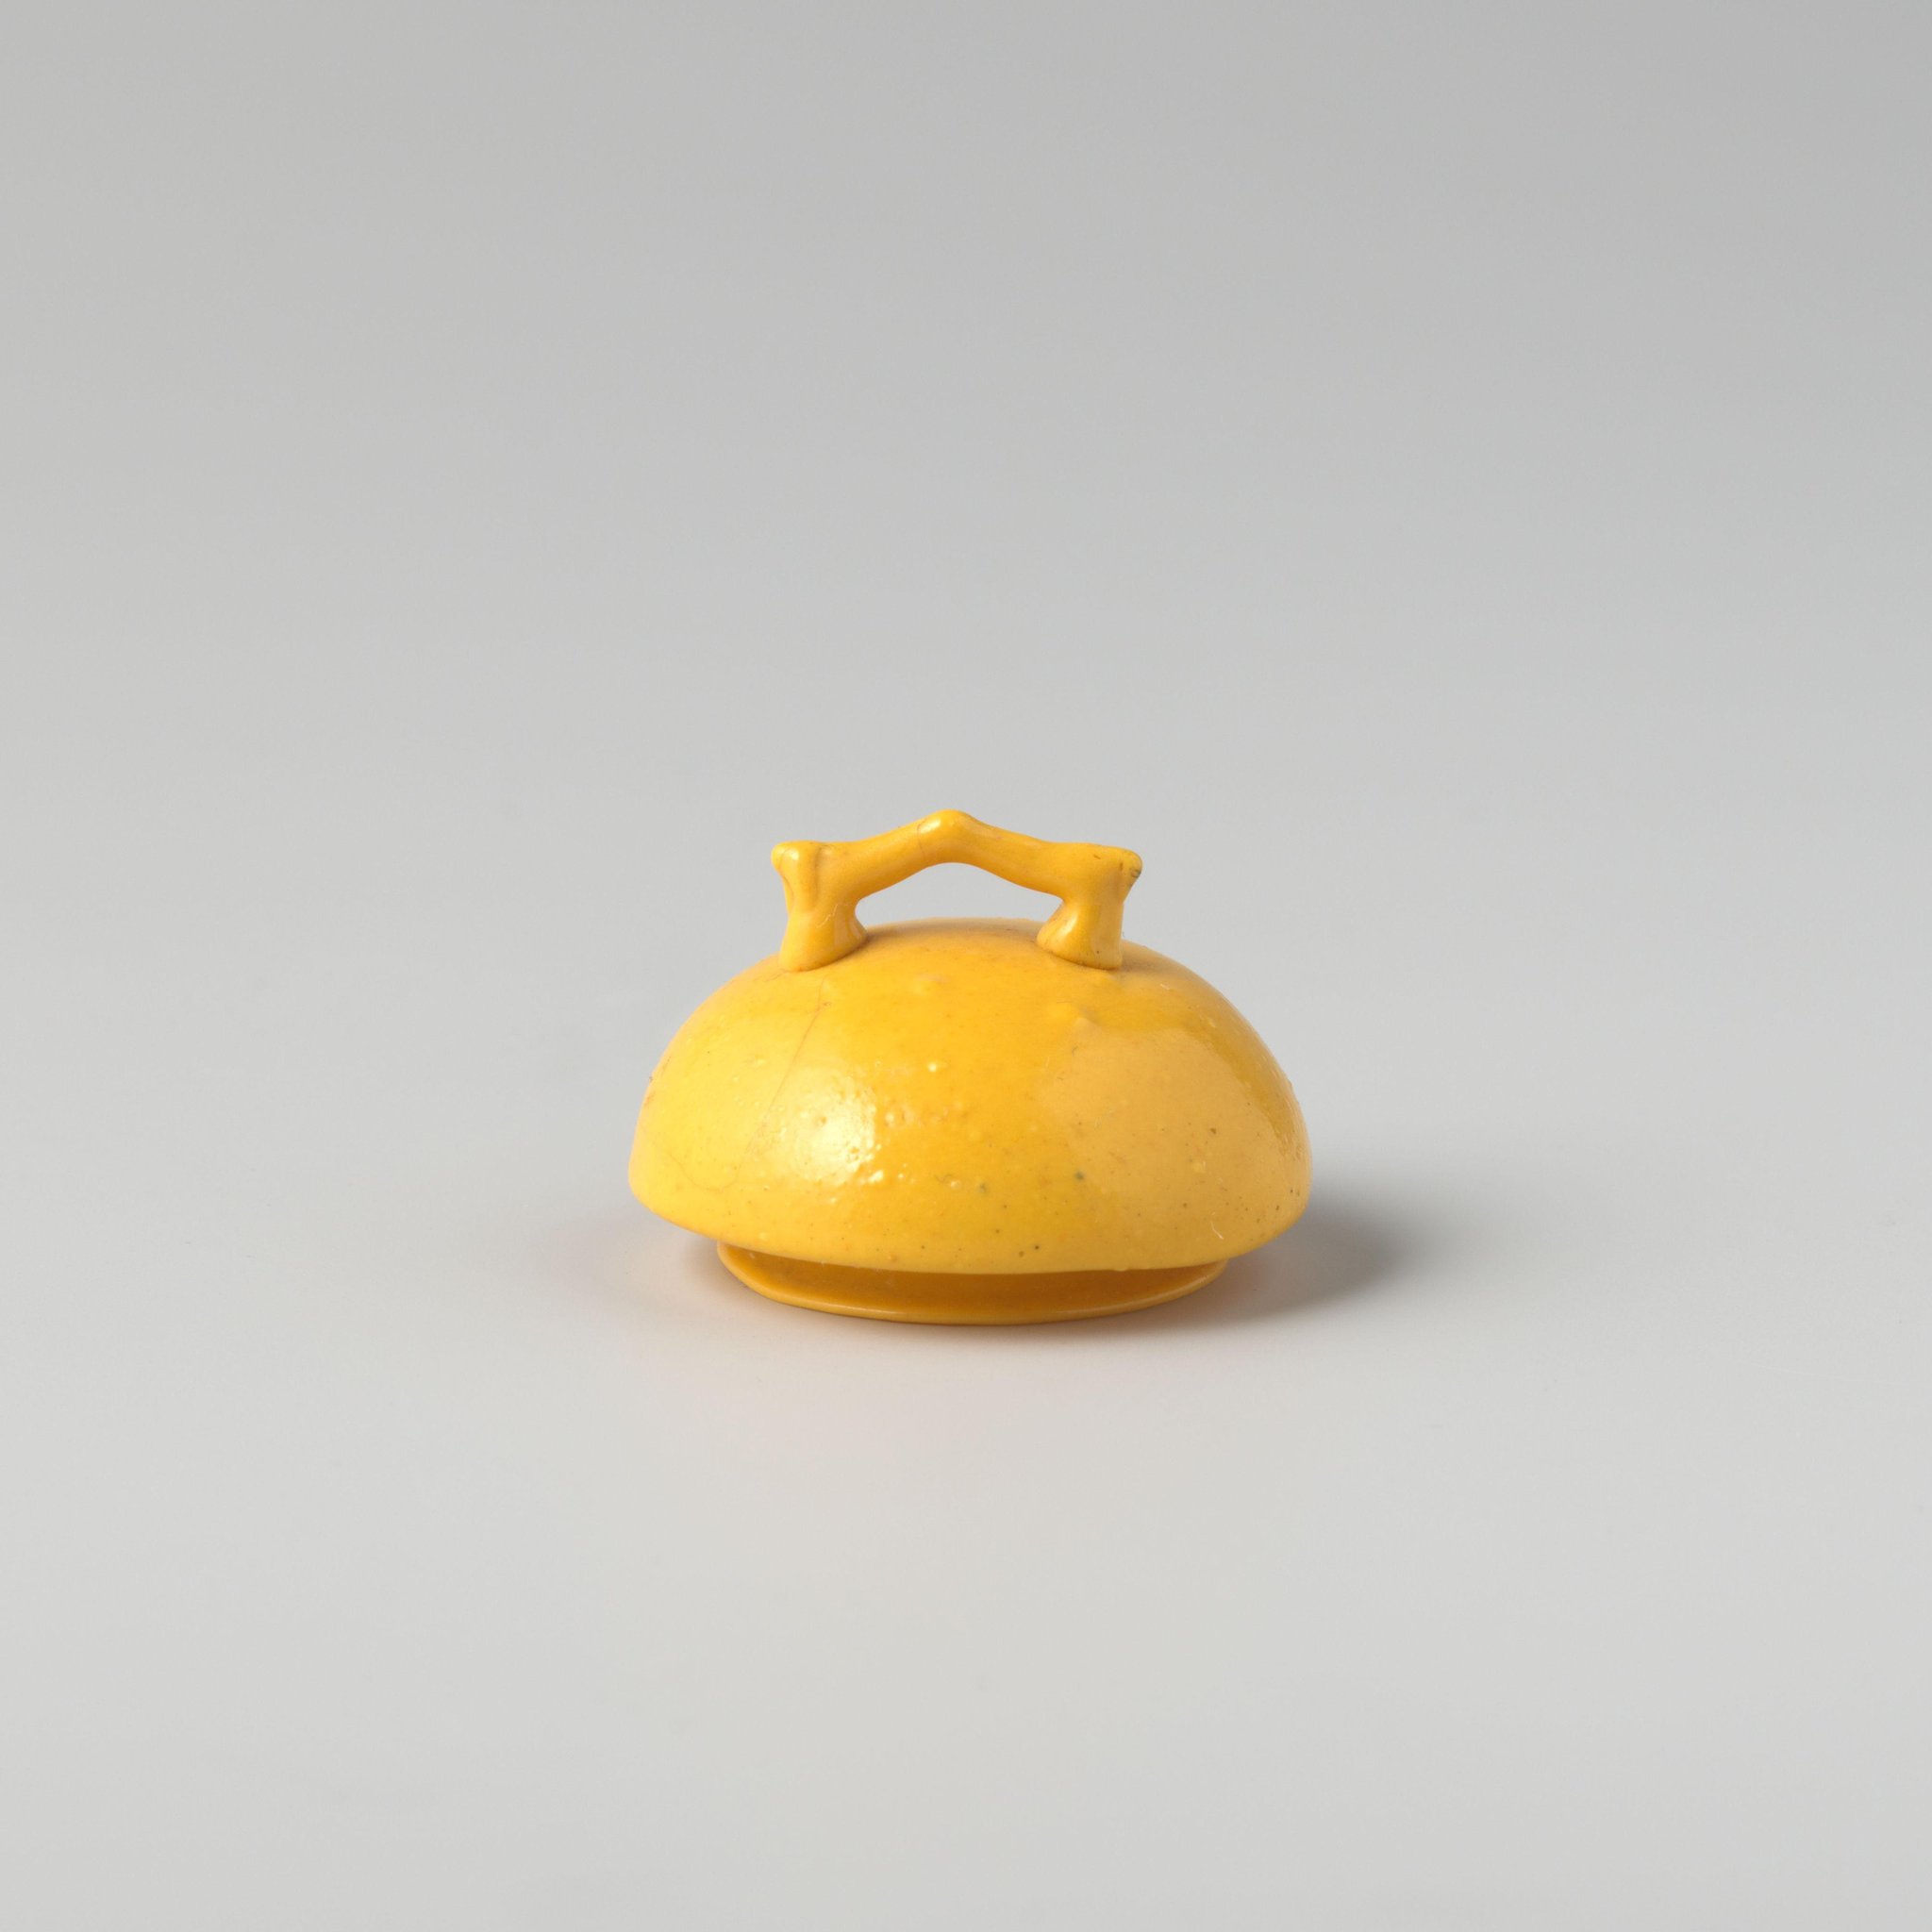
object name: lid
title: Deksel of stolp van opaak geel glas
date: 1675-1700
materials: glass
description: Deksel of stolp van opaak geel glas, met rechthoekig handvat en naar binnen gesnoerde halsrand.